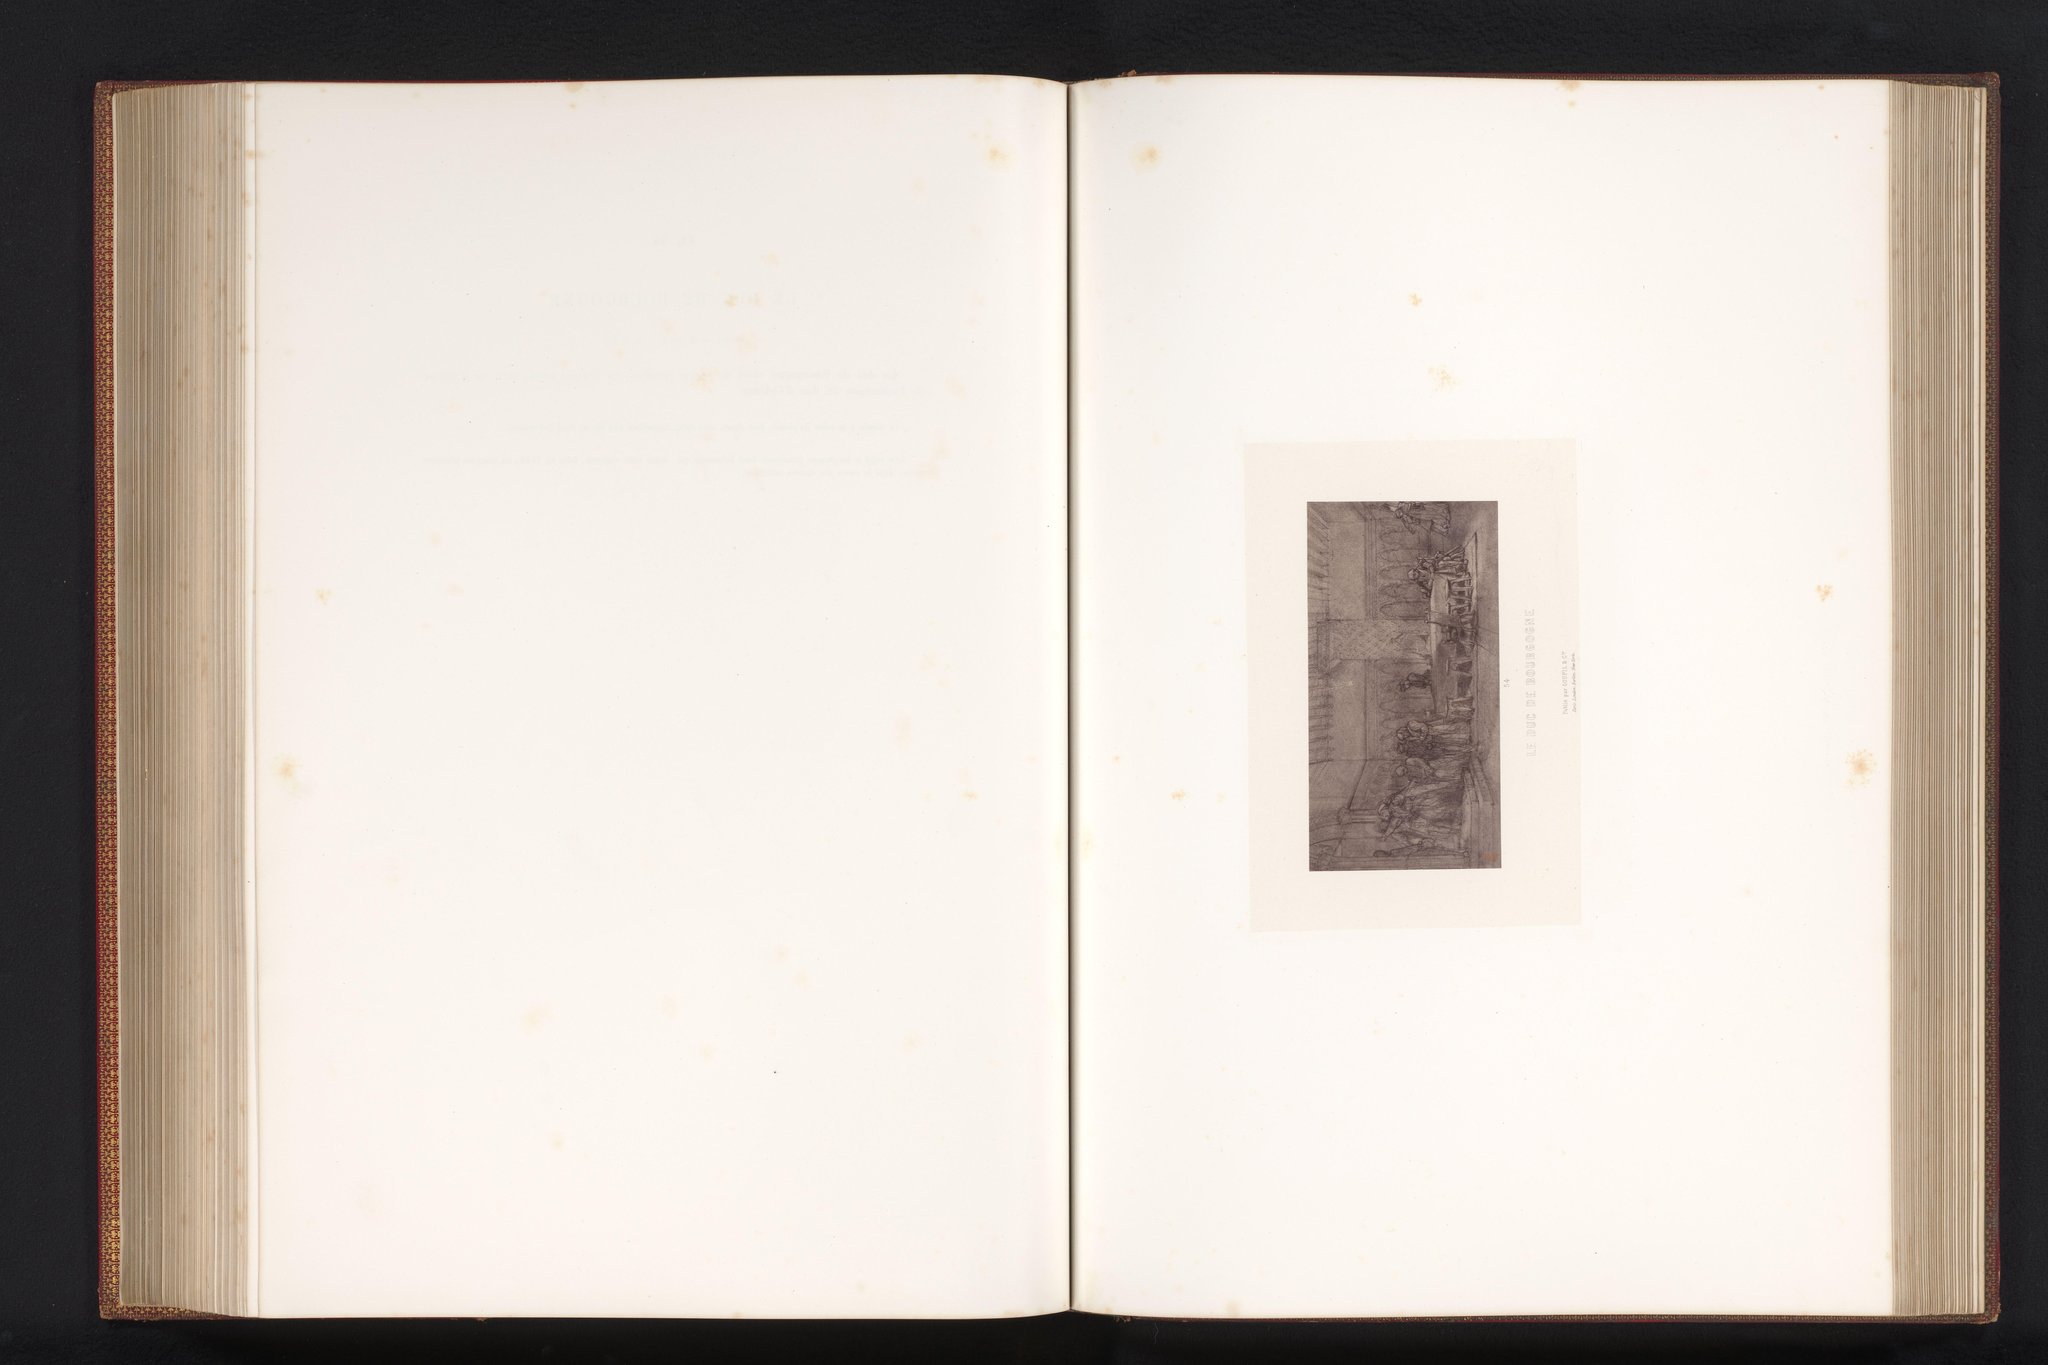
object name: page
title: Fotoreproductie van een tekening van de hertog van Bourgondië door Paul Delaroche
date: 1853-1858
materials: paper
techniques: albumen print, engraving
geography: paris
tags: court ceremonial, court etiquette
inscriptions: initials: ‘GC’